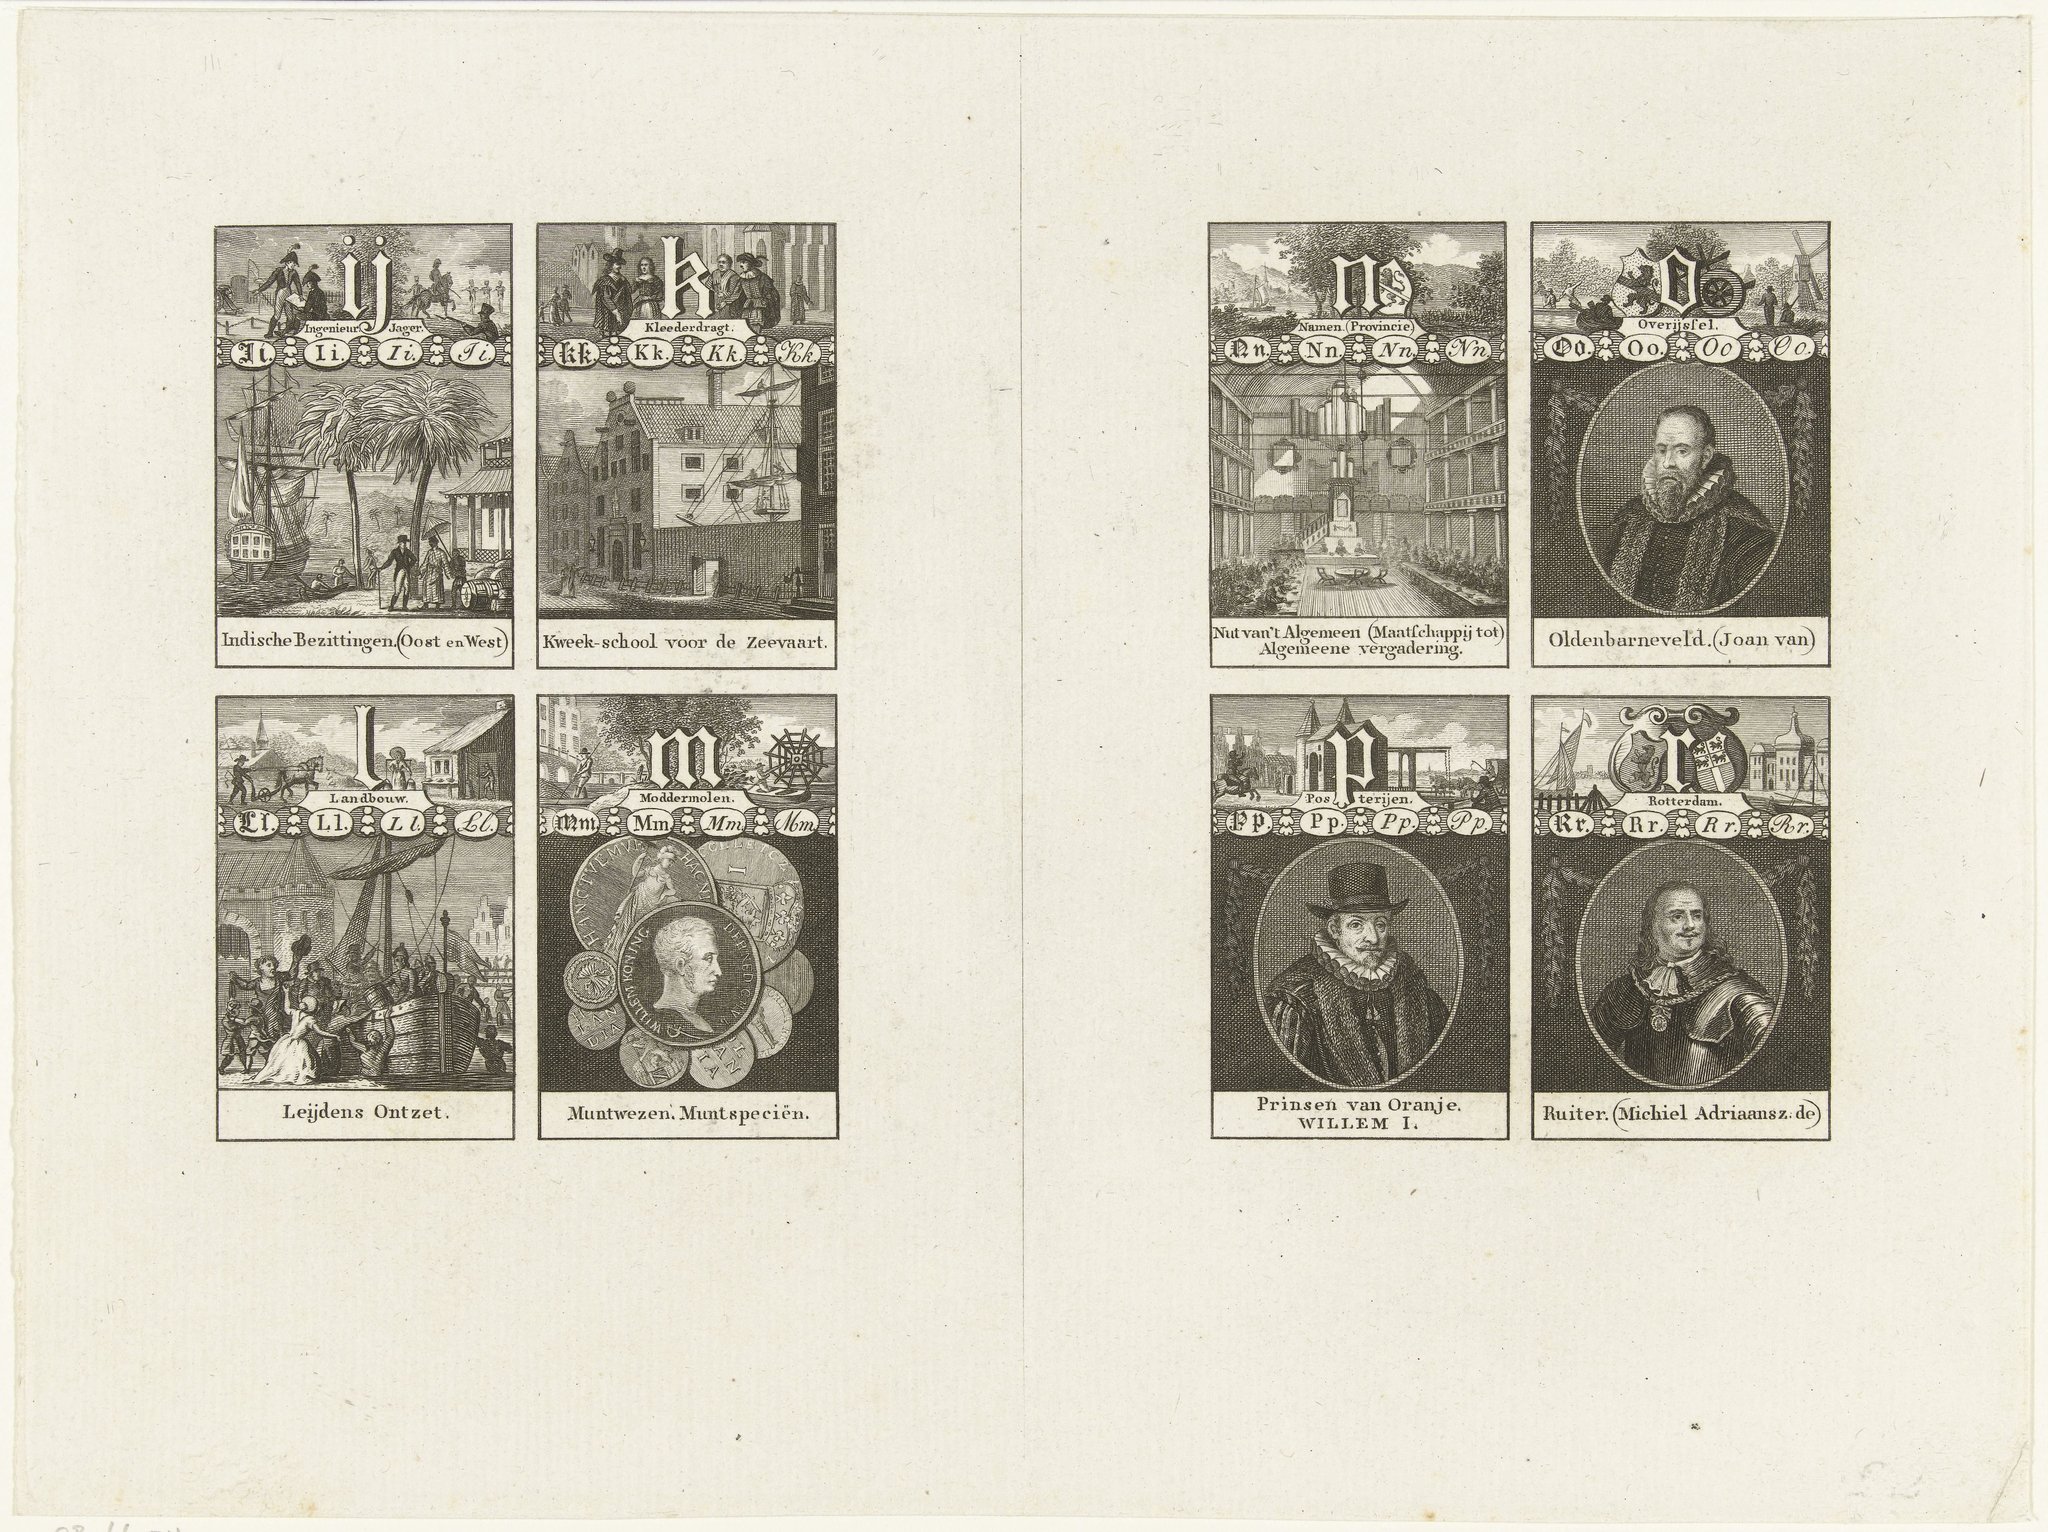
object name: print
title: Blad I/K/L/M en blad N/O/P/R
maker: philippus velijn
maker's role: print maker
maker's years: 1787-1836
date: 1821-1823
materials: paper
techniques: engraving, etching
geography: netherlands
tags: the hague, johan van oldenbarnevelt, flushing, michiel adriaenszoon de ruyter, delft, william i (prince of orange), netherlands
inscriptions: collector's mark: Lugt 2228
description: Blad voor de letters I: bezittingen in Oost-Indië en West-Indië, K: Kweekschool voor de zeevaart, L: Leids Ontzet, M: Muntwezen, N: Maatschappij tot Nut van 't Algemeen, O: Johan van Oldenbarneveld, P: Prins Willem I van Oranje, R: Michiel Adriaenszoon de Ruyter.